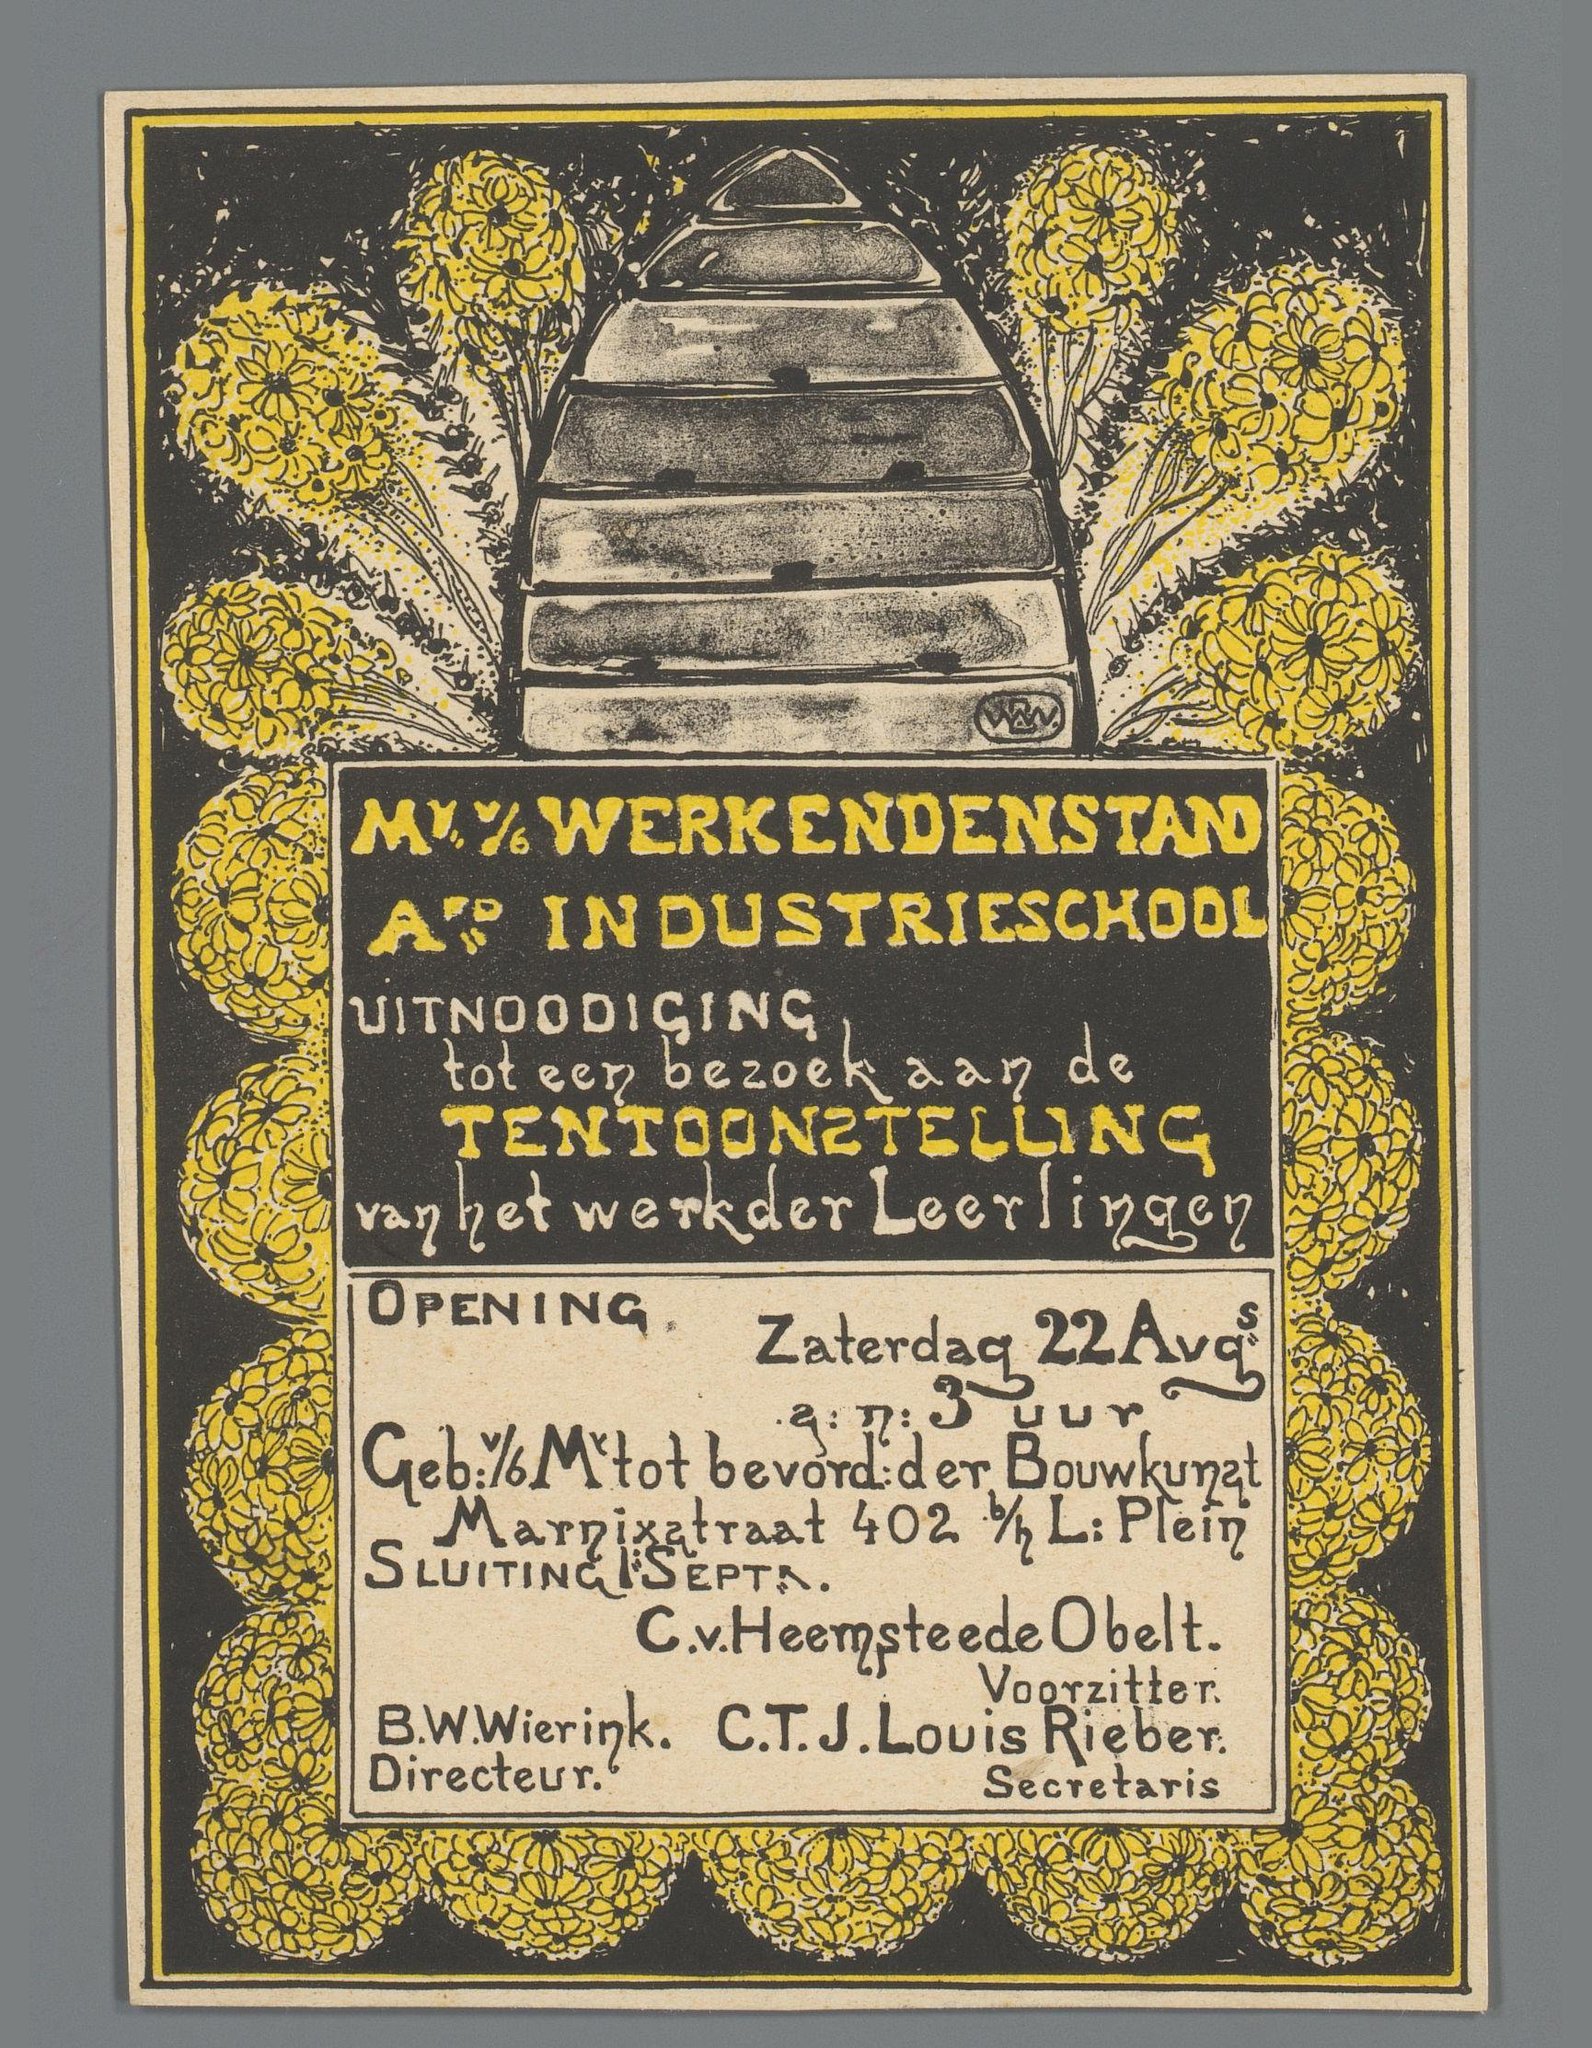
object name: invitation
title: Uitnodiging voor de tentoonstelling van werk van de leerlingen van de Afdeling Industrieschool van de Maatschappij voor den Werkenden Stand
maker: bernard willem wierink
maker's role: draughtsman, print maker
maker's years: 1856-1939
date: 1866-1939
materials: paper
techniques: lithograph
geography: amsterdam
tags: flowers, bee-hive, collection, exhibition, show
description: Een kader van bloemen en bovenaan een bijenkorf. Daaronder de tekst van de uitnodiging voor de tentoonstelling die gehouden werd van 22 augustus in het gebouw van de Maatschappij tot bevordering der Bouwkunst.